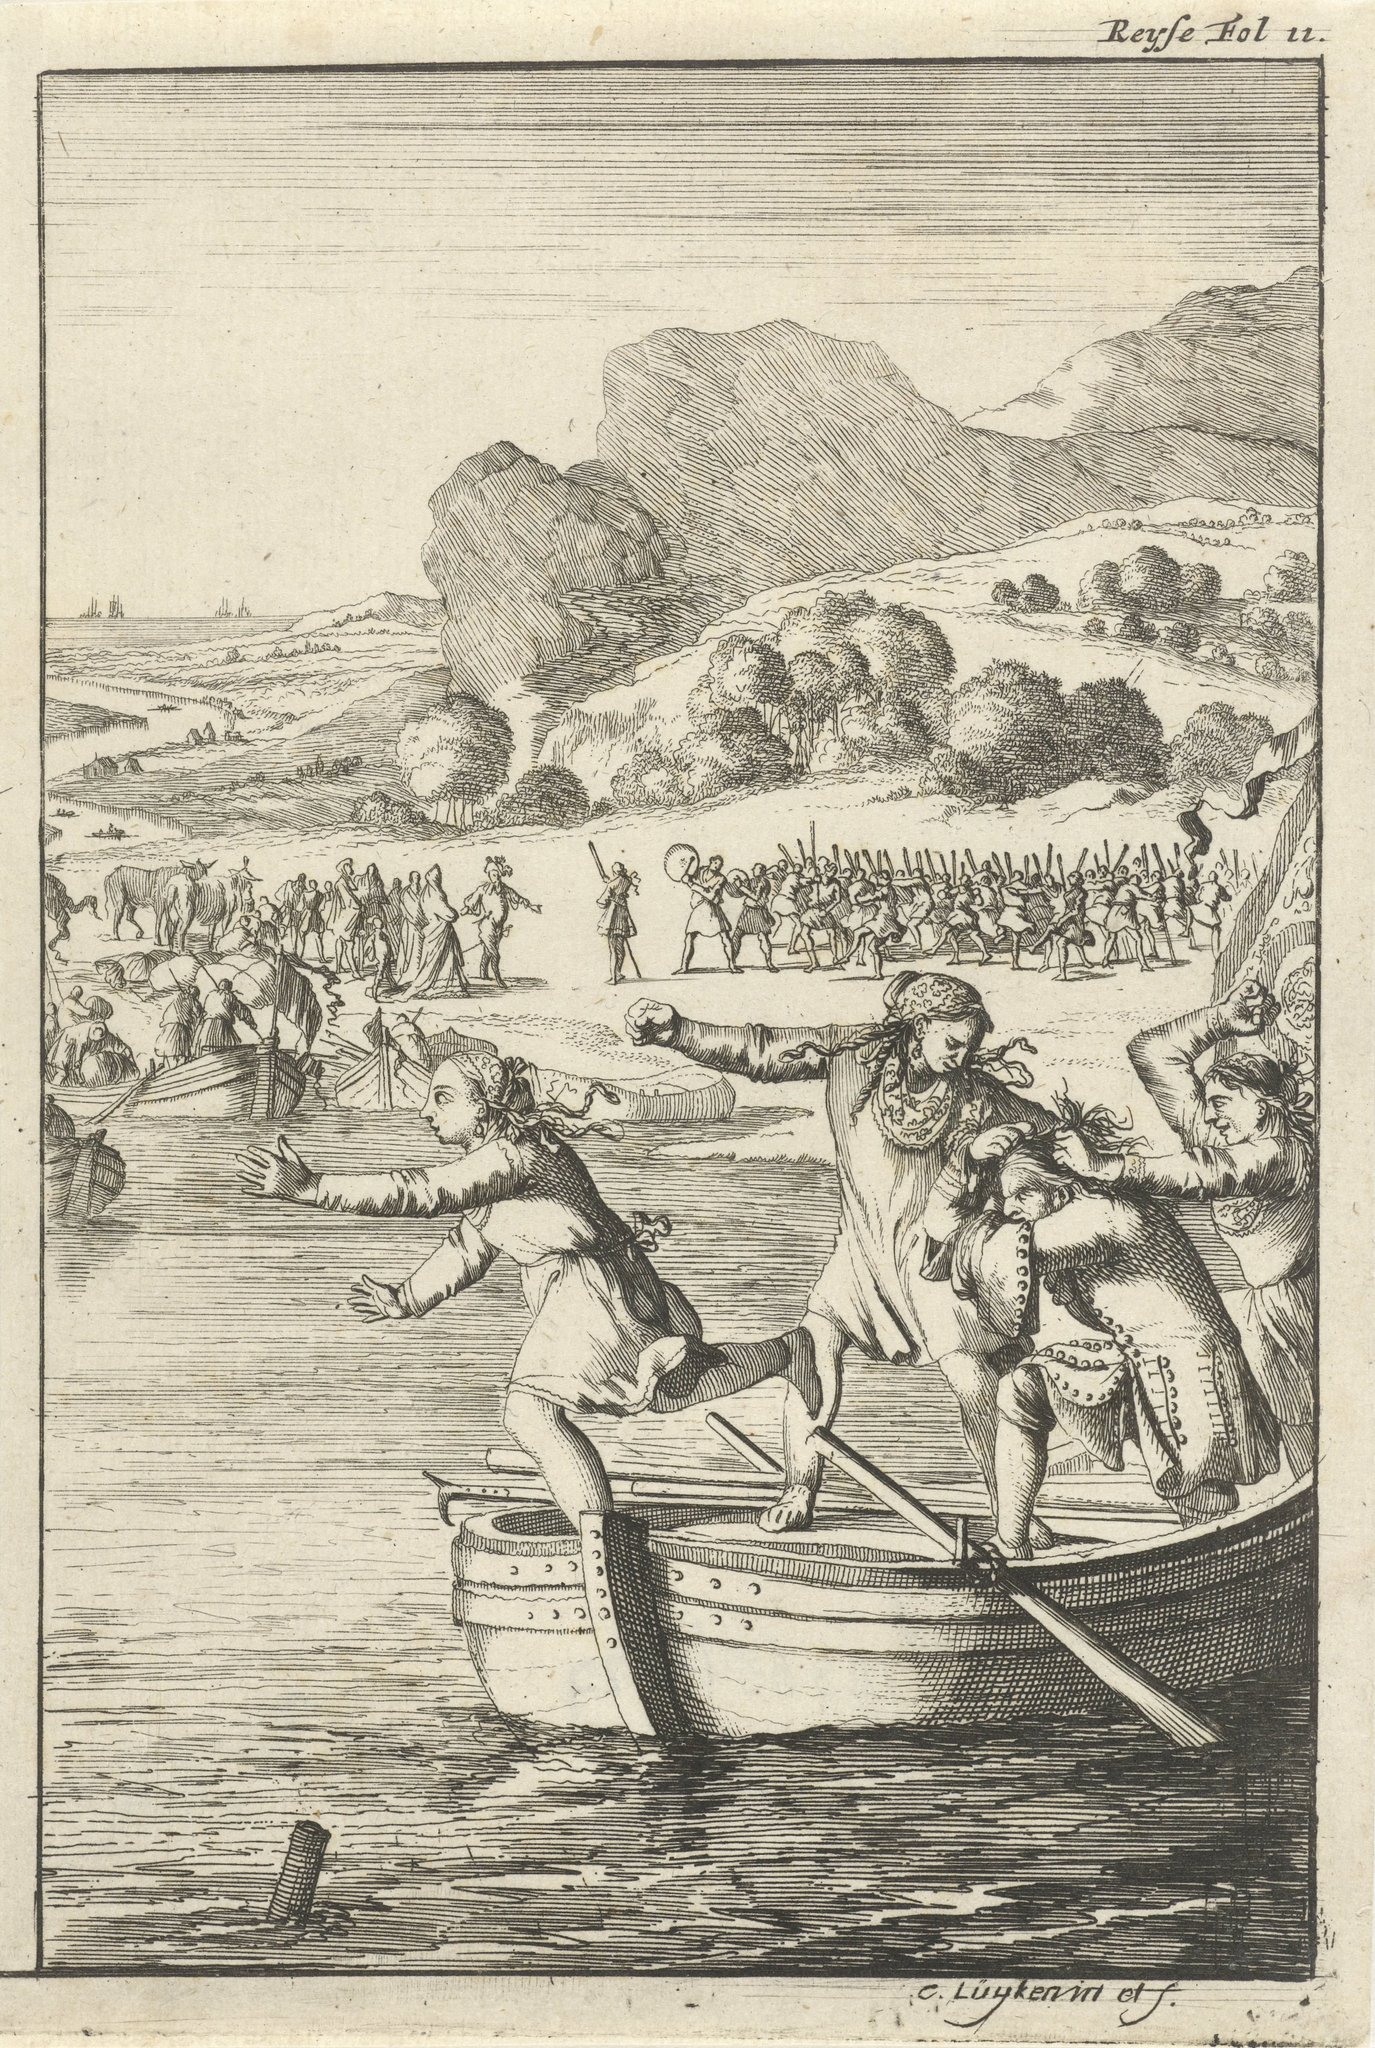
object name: book illustration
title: Kok van Marie-Catherine d'Aulnoy ruziet op een roeiboot met enkele meisjes uit Biskaje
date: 1696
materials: paper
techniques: etching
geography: utrecht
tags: cook, rowing-boat, canoe, etc., quarrel, argument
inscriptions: collector's mark: Lugt 2228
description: Illustratie uit: D'Aulnoy, Marie Cathérine Le Jumel de Barneville. Reyse door Spaignien, neffens memorien van des selfs hofs. Utrecht: Willem Broedelet, 1696.